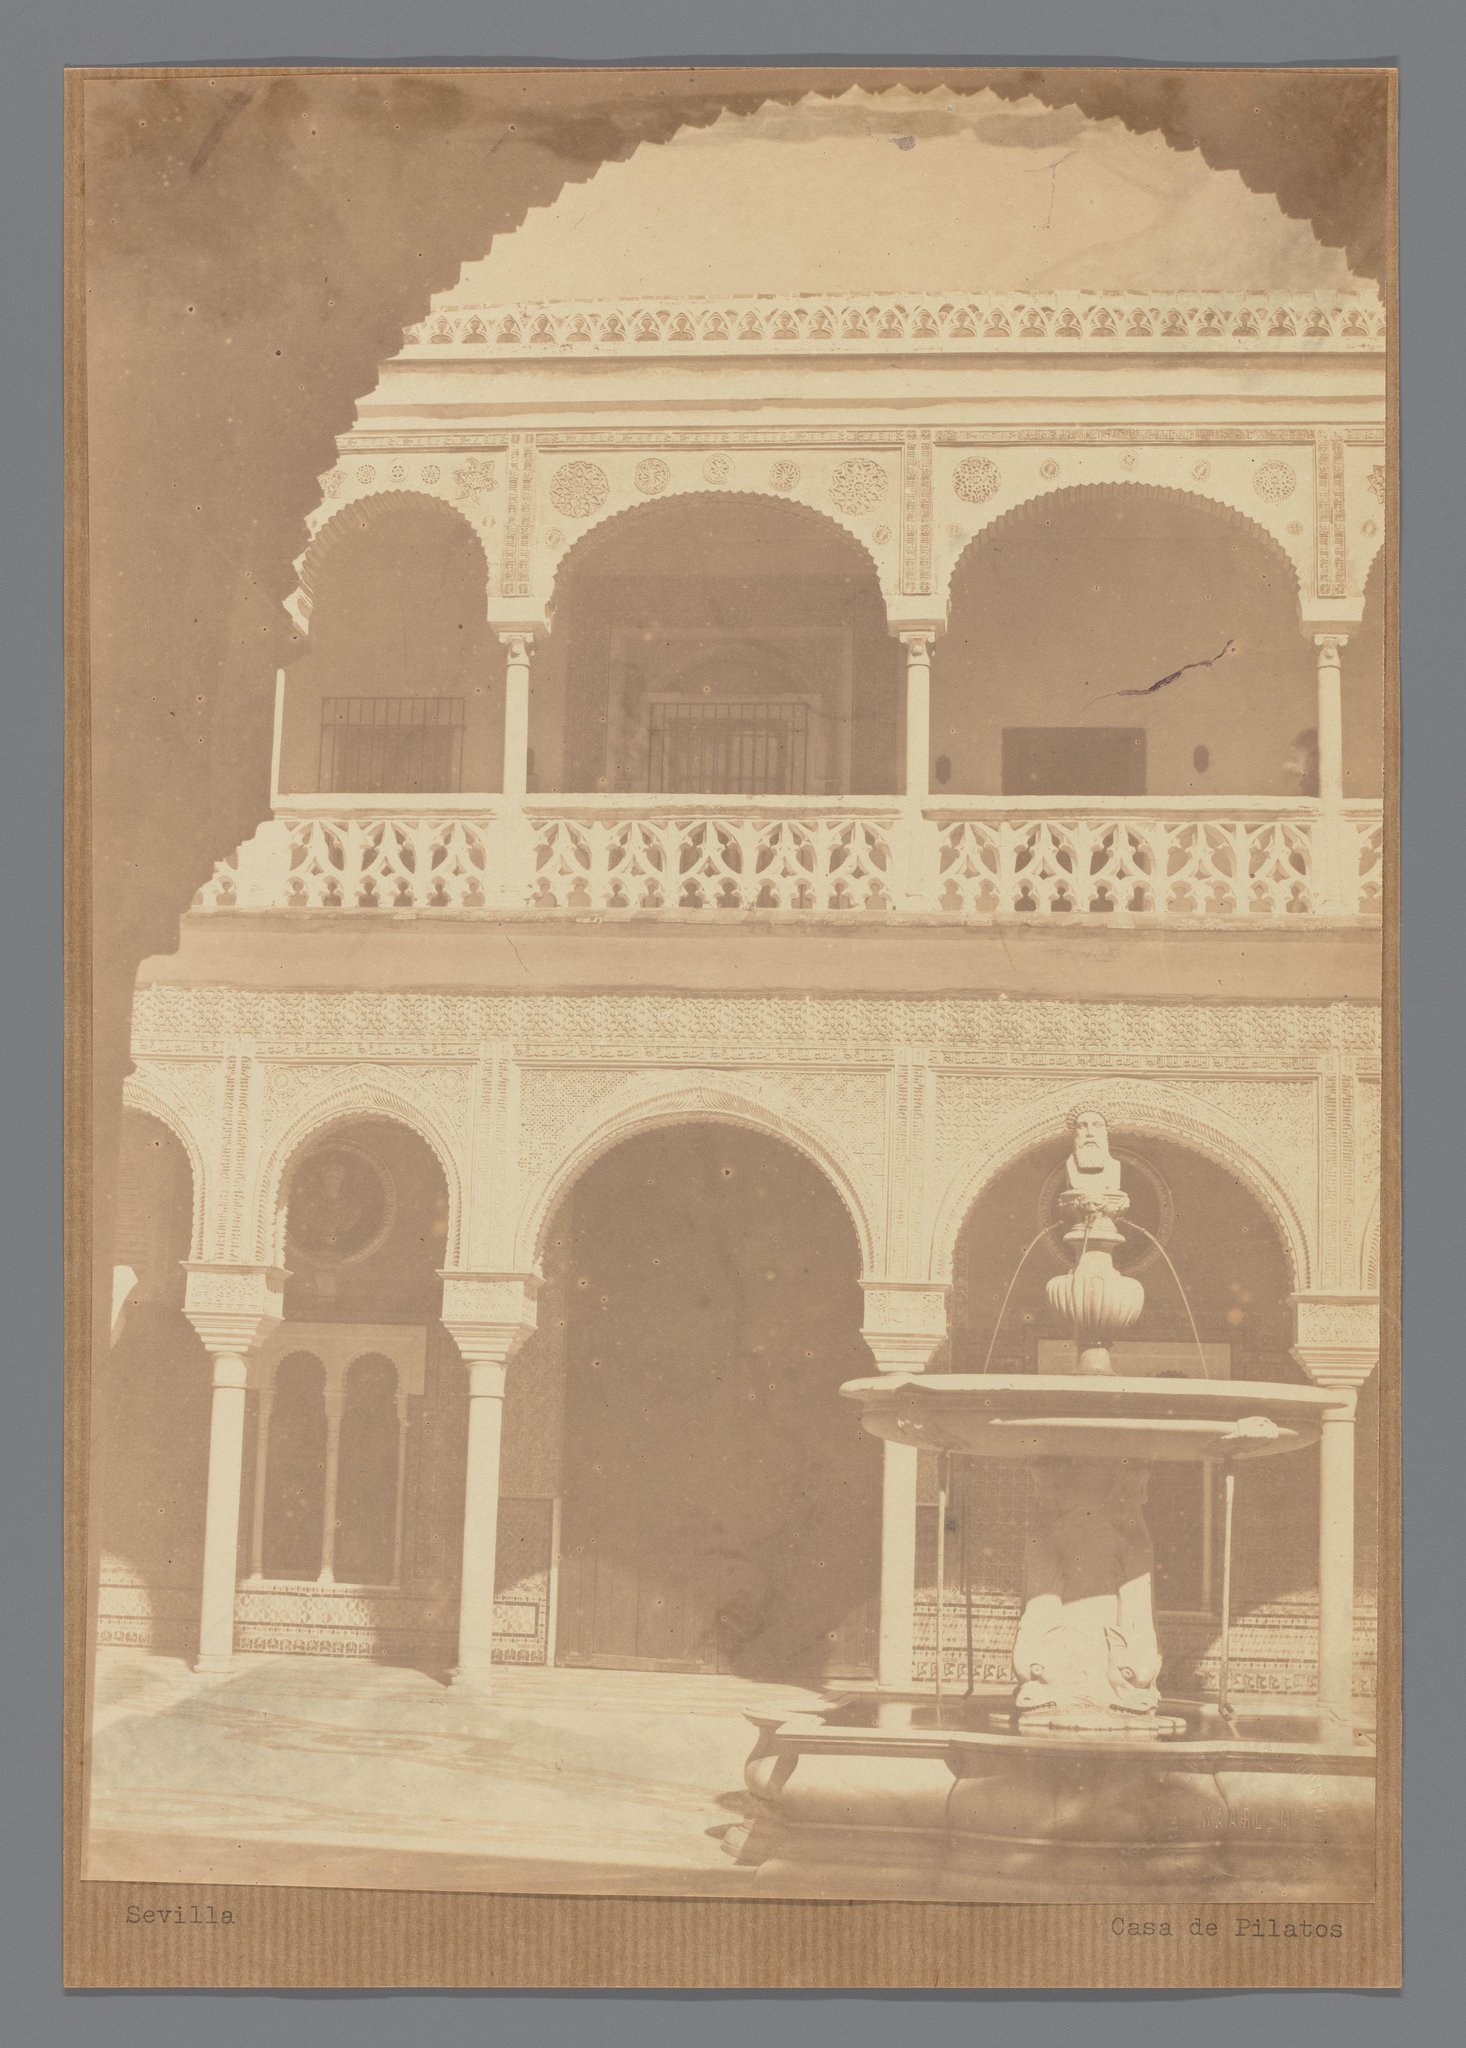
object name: photograph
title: Fontein op de binnenplaats Casa de Pilatos, Sevilla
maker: manuel freyre reynoso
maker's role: fotograaf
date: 1850-1899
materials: paper, photographic support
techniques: albumen print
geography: spain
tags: garden fountain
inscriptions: stamp: ‘UNIVERSITEIT VAN AMSTERDAM / KUNST / HISTORISCH / INSTITUUT’, inscription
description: Foto uit de studiecollectie van het Kunsthistorisch Instituut van de Universiteit van Amsterdam.